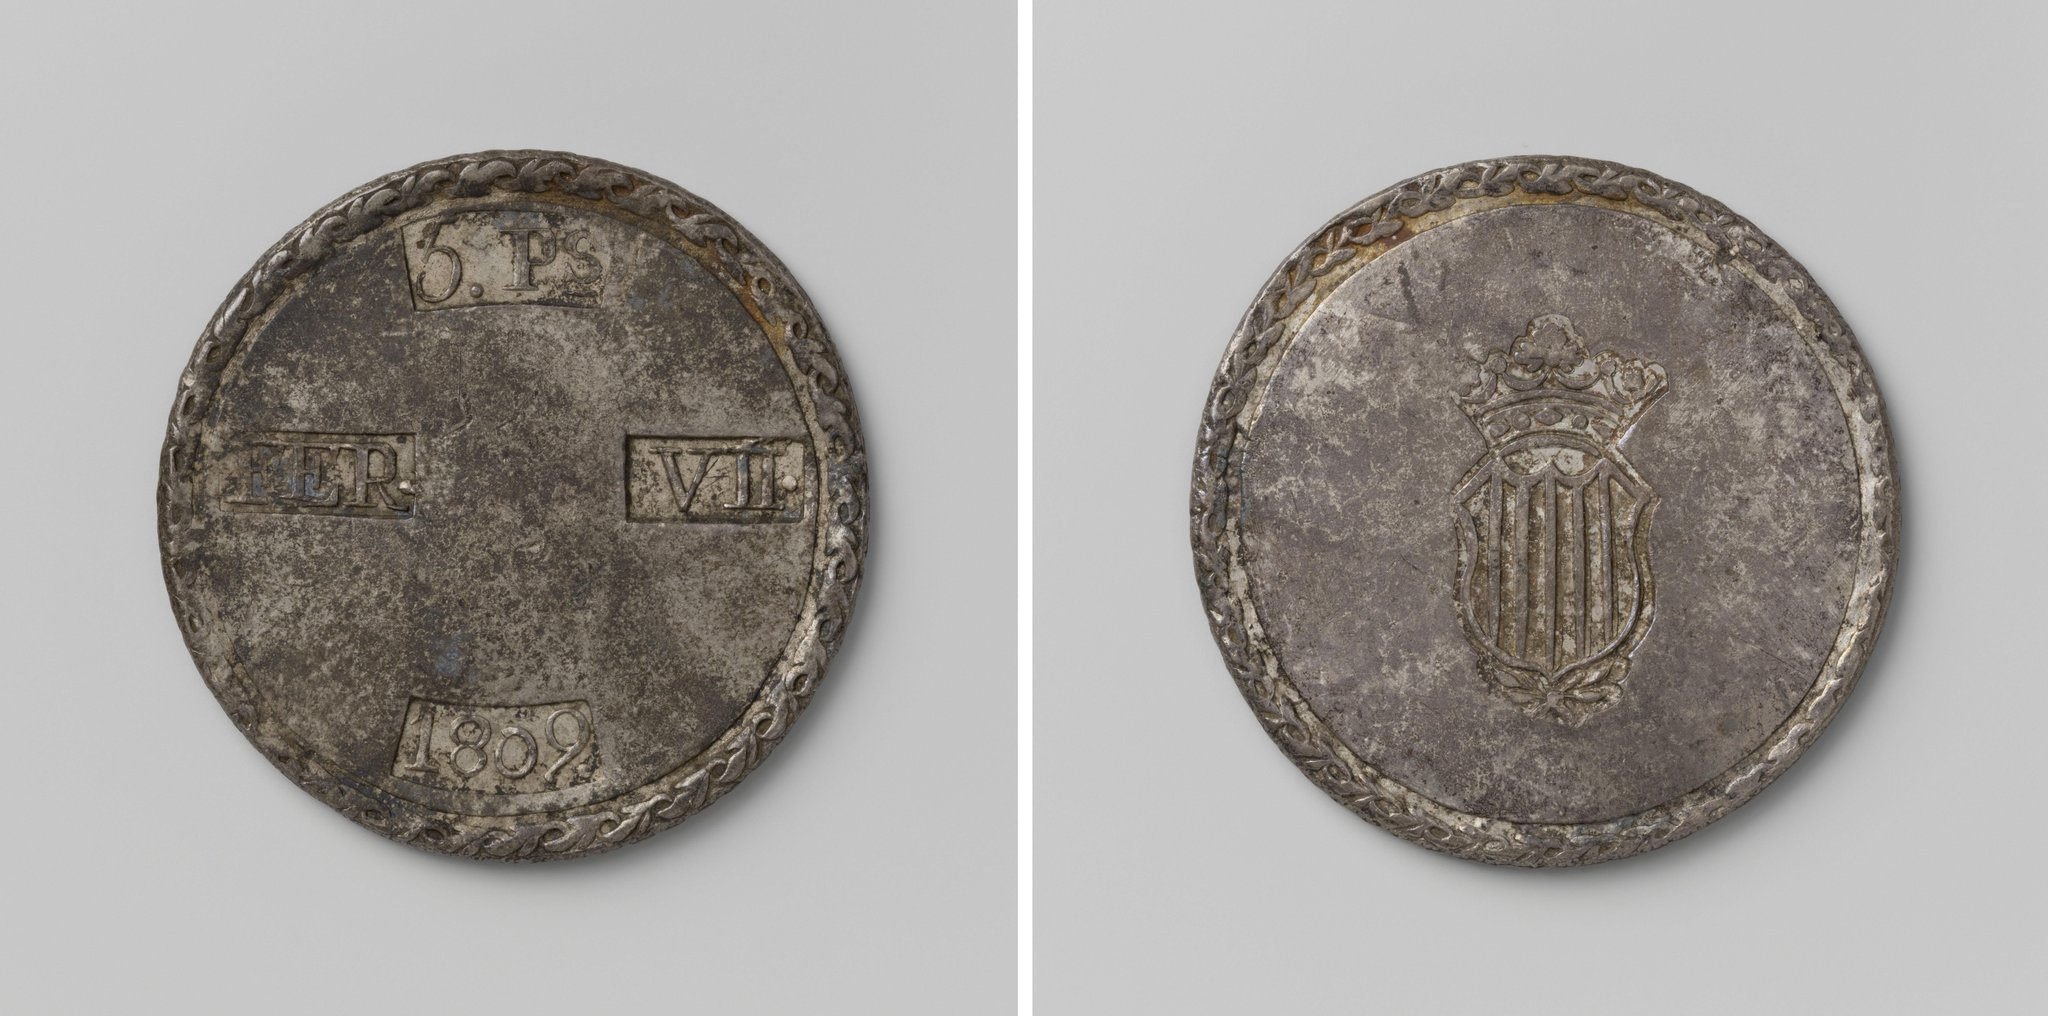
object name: siege coin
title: Beleg van Tarrgona door de Fransen, noodmunt van vijf pesetas, geslagen door Ferdinand VII, koning van Spanje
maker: Anonymous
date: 1809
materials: silver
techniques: striking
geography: tarragona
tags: ferdinand vii (koning van spanje)